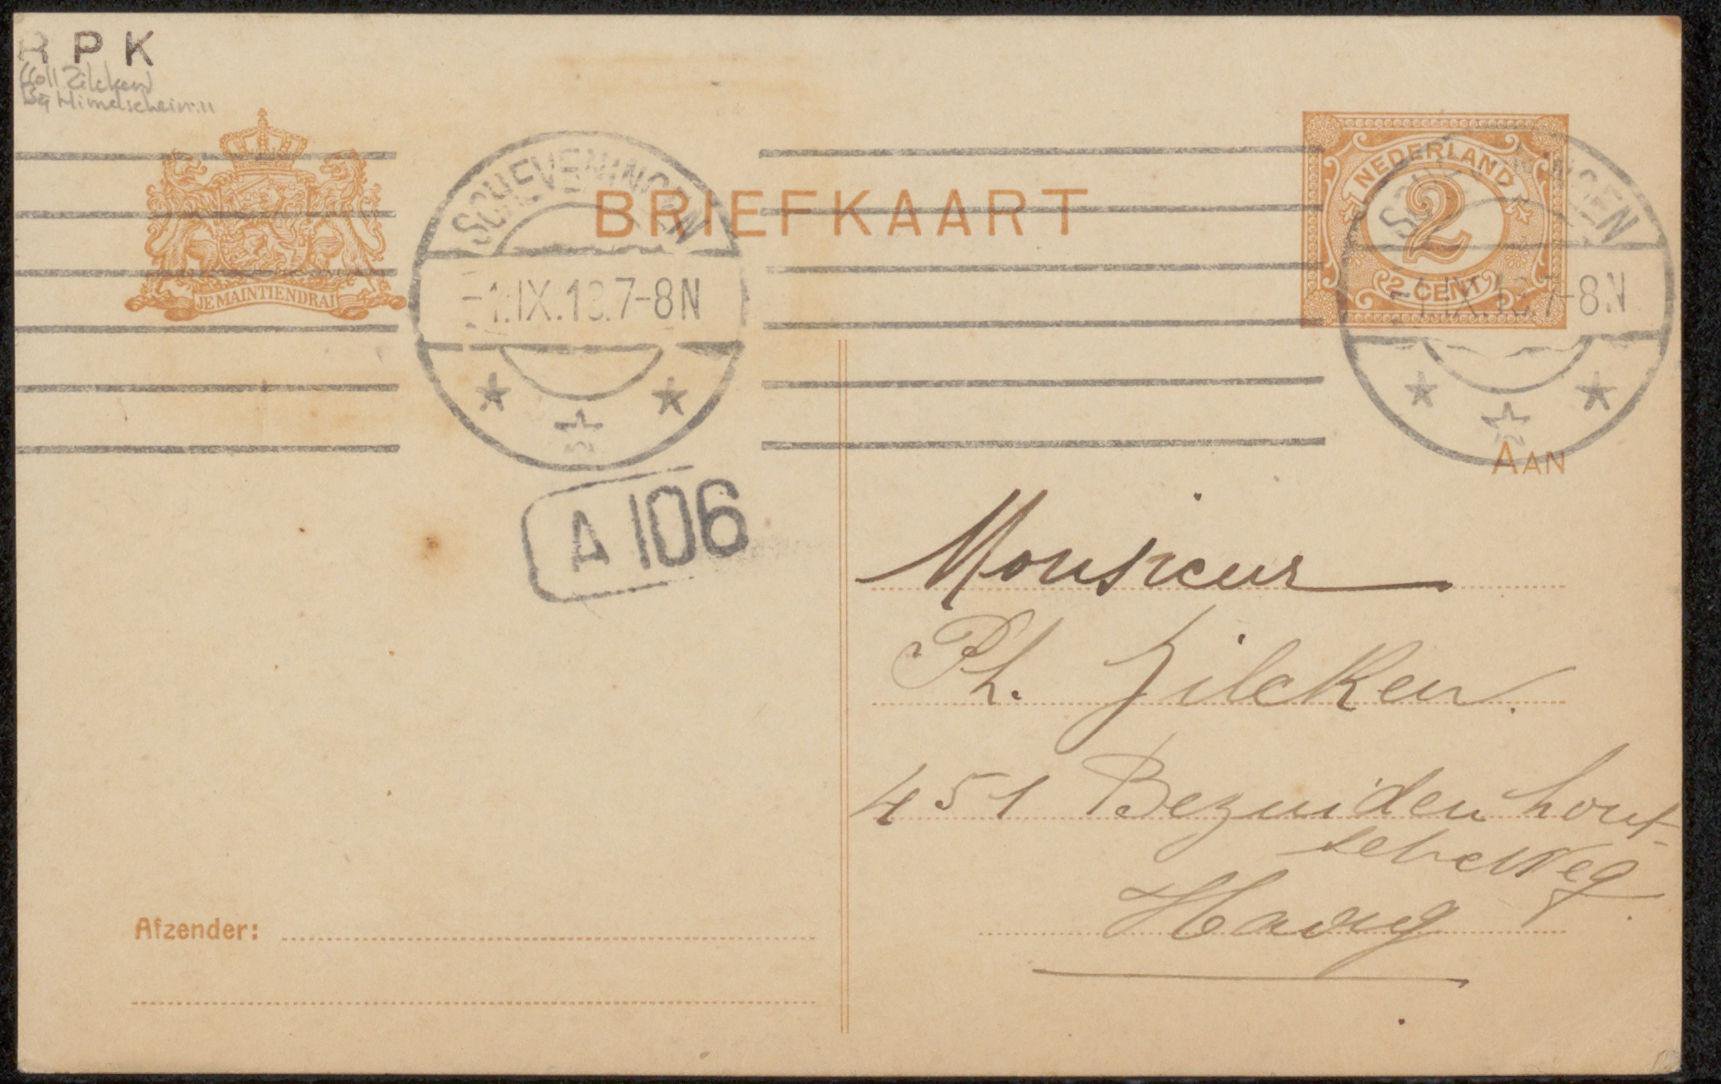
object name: postcard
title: Briefkaart aan Philip Zilcken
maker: rose imel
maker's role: draughtsman, painter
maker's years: 1901-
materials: cardboard, ink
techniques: pen, writing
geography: scheveningen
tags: the hague, painter, draughtsman, philip zilcken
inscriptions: collector's mark: ‘RPK’